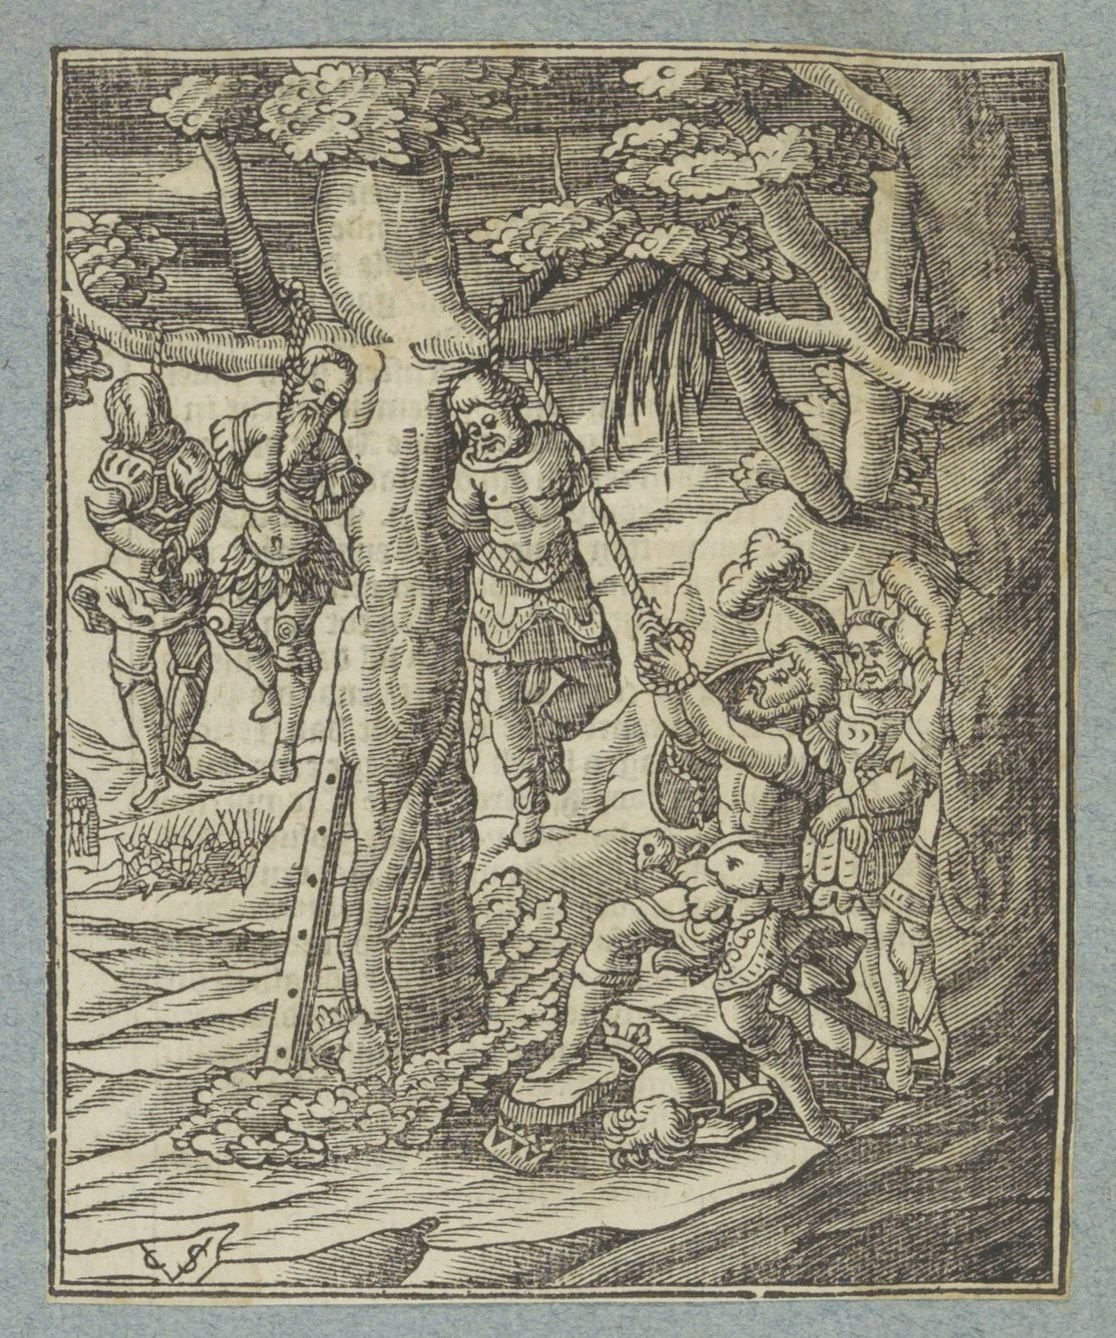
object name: book illustration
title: Vijf Amoritische koningen opgehangen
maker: pieter jacobsz. paets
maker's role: publisher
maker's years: 1587-1667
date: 1645-1646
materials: paper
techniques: letterpress printing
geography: amsterdam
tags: the five amorite kings are killed either on joshua's command or by his own hand, and their bodies are hanged as a display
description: De prent werd gemaakt voor de uitgaven van P.J. Paets uit Amsterdam. Ze komt in ieder geval voor in: Bibels Tresoor ofte der zielen lusthof. Amsterdam, P.J. Paets, 1646. Mogelijk ook in: Historien ende Prophetien. [Amsterdam], P.J. Paets, 1645.